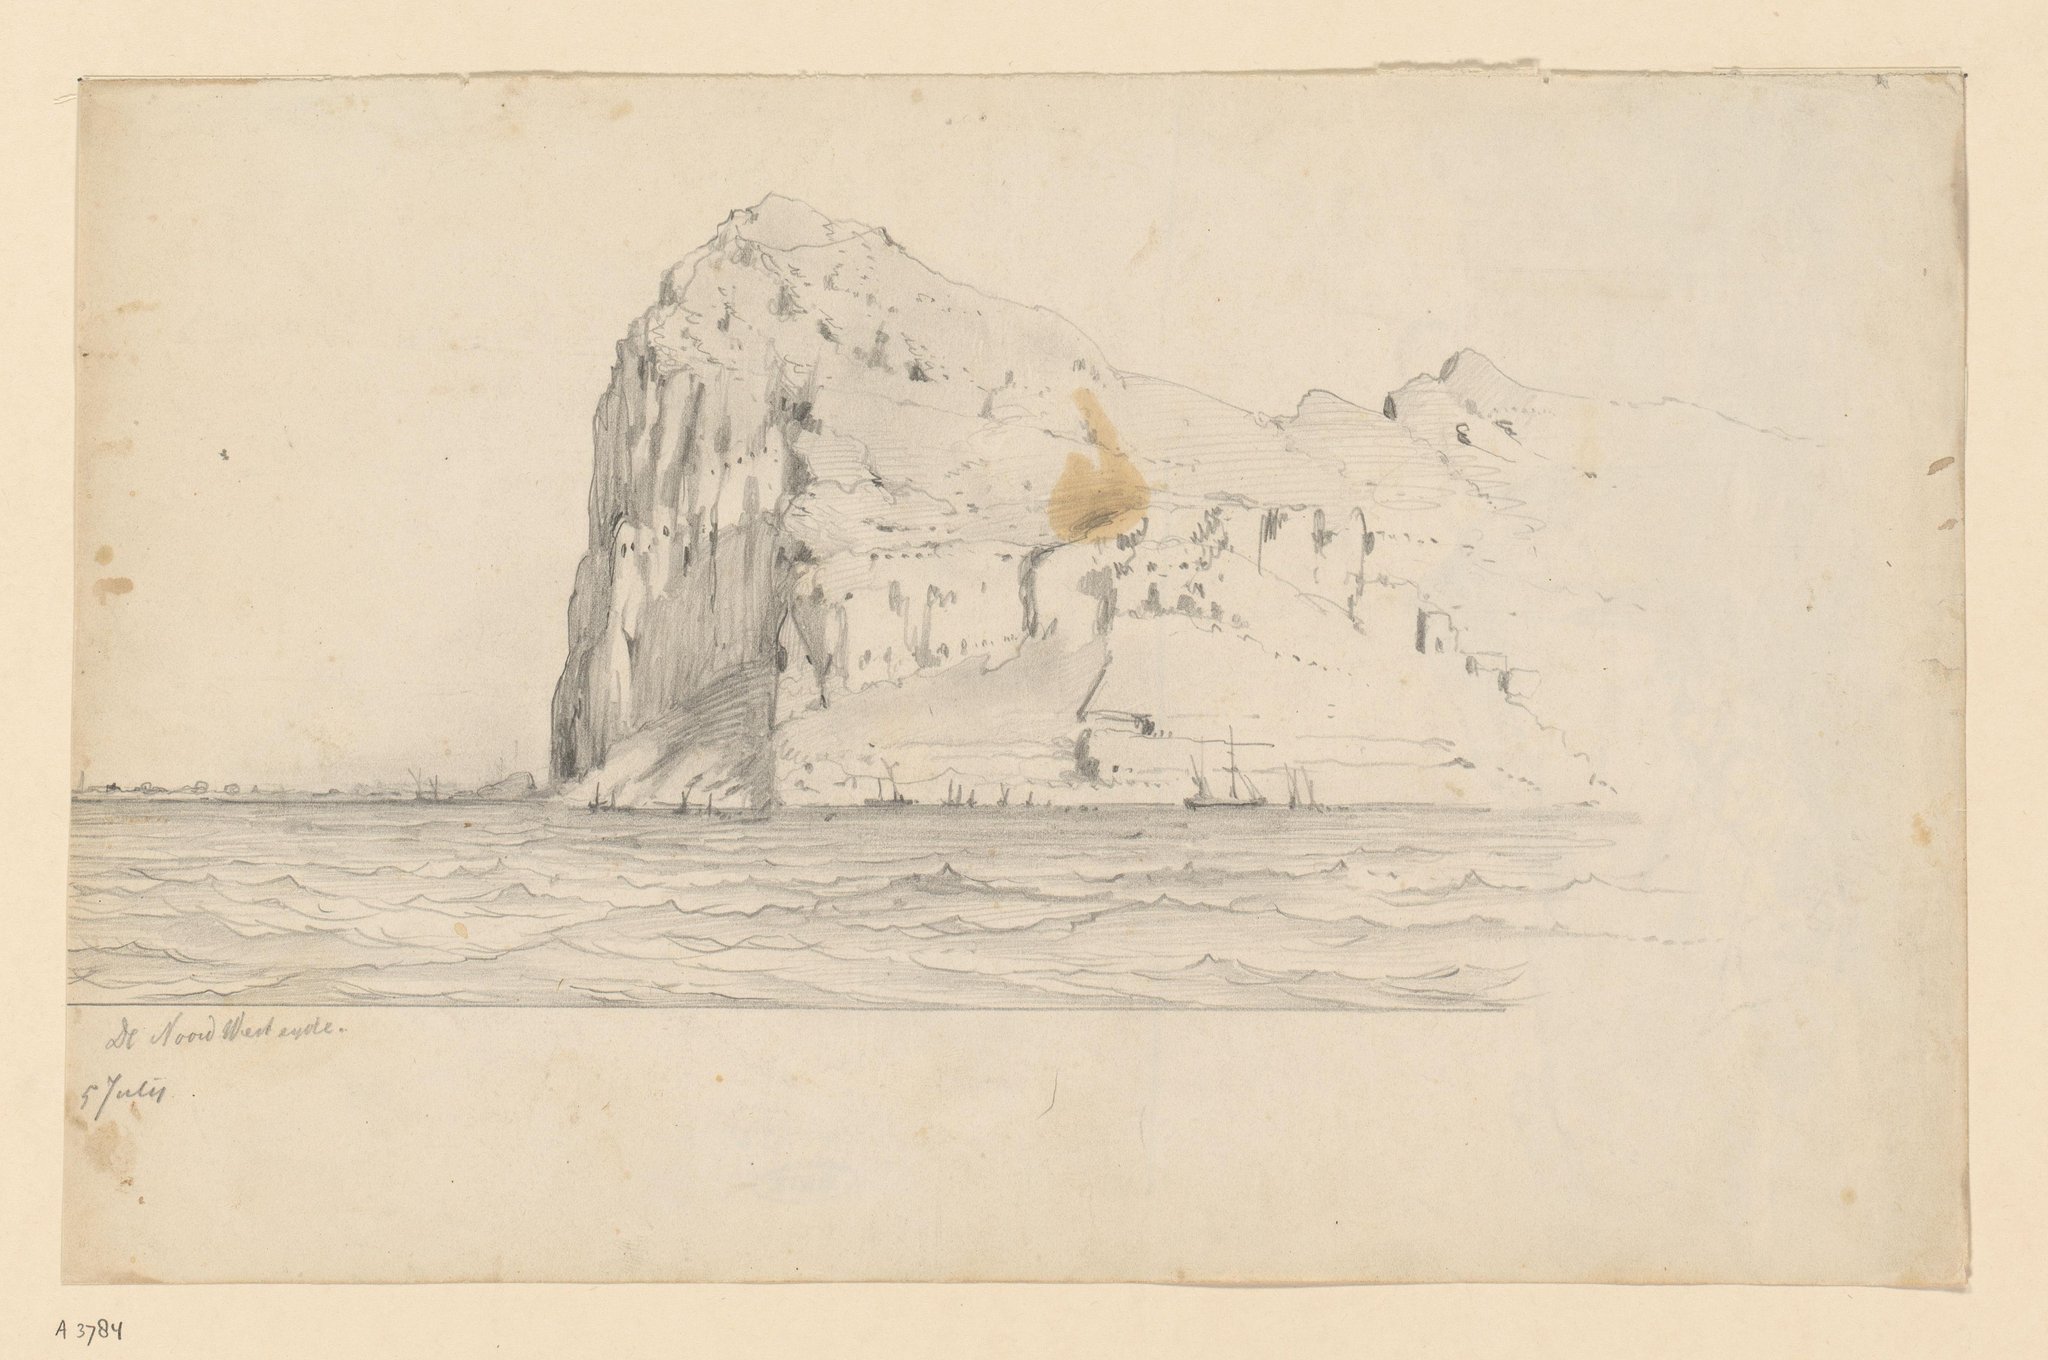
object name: drawing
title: De rots van Gibraltar (de Noordwestzijde)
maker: willem anthonie van deventer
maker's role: draughtsman, painter, print maker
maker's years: 1824-1893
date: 1834-1893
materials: paper, pencil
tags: rock-formations